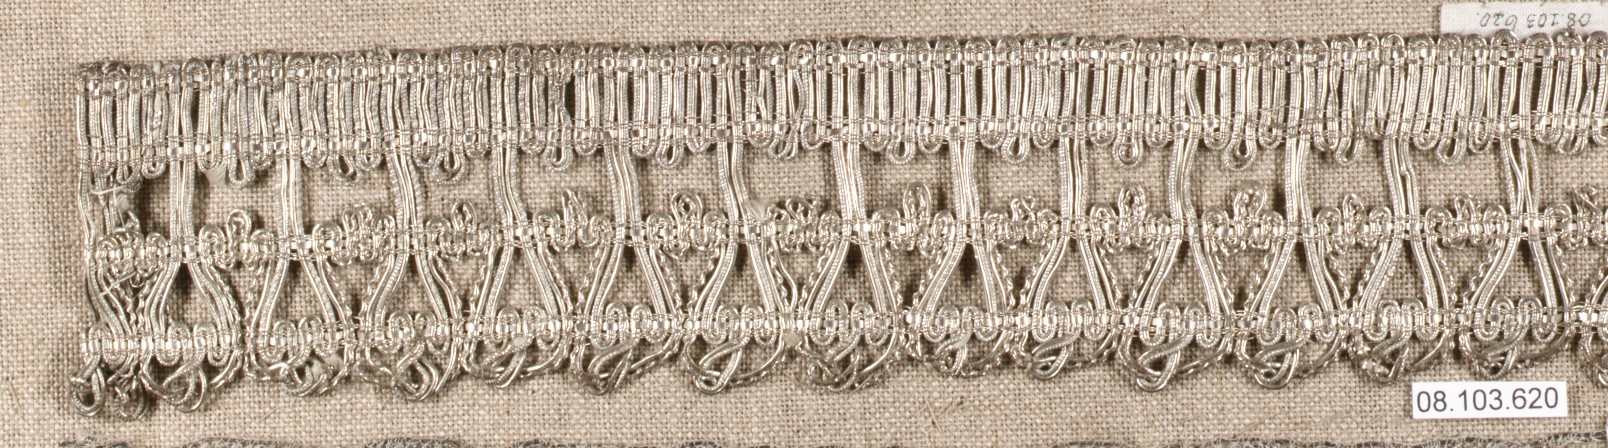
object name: galloon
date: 1601-1700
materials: metal thread